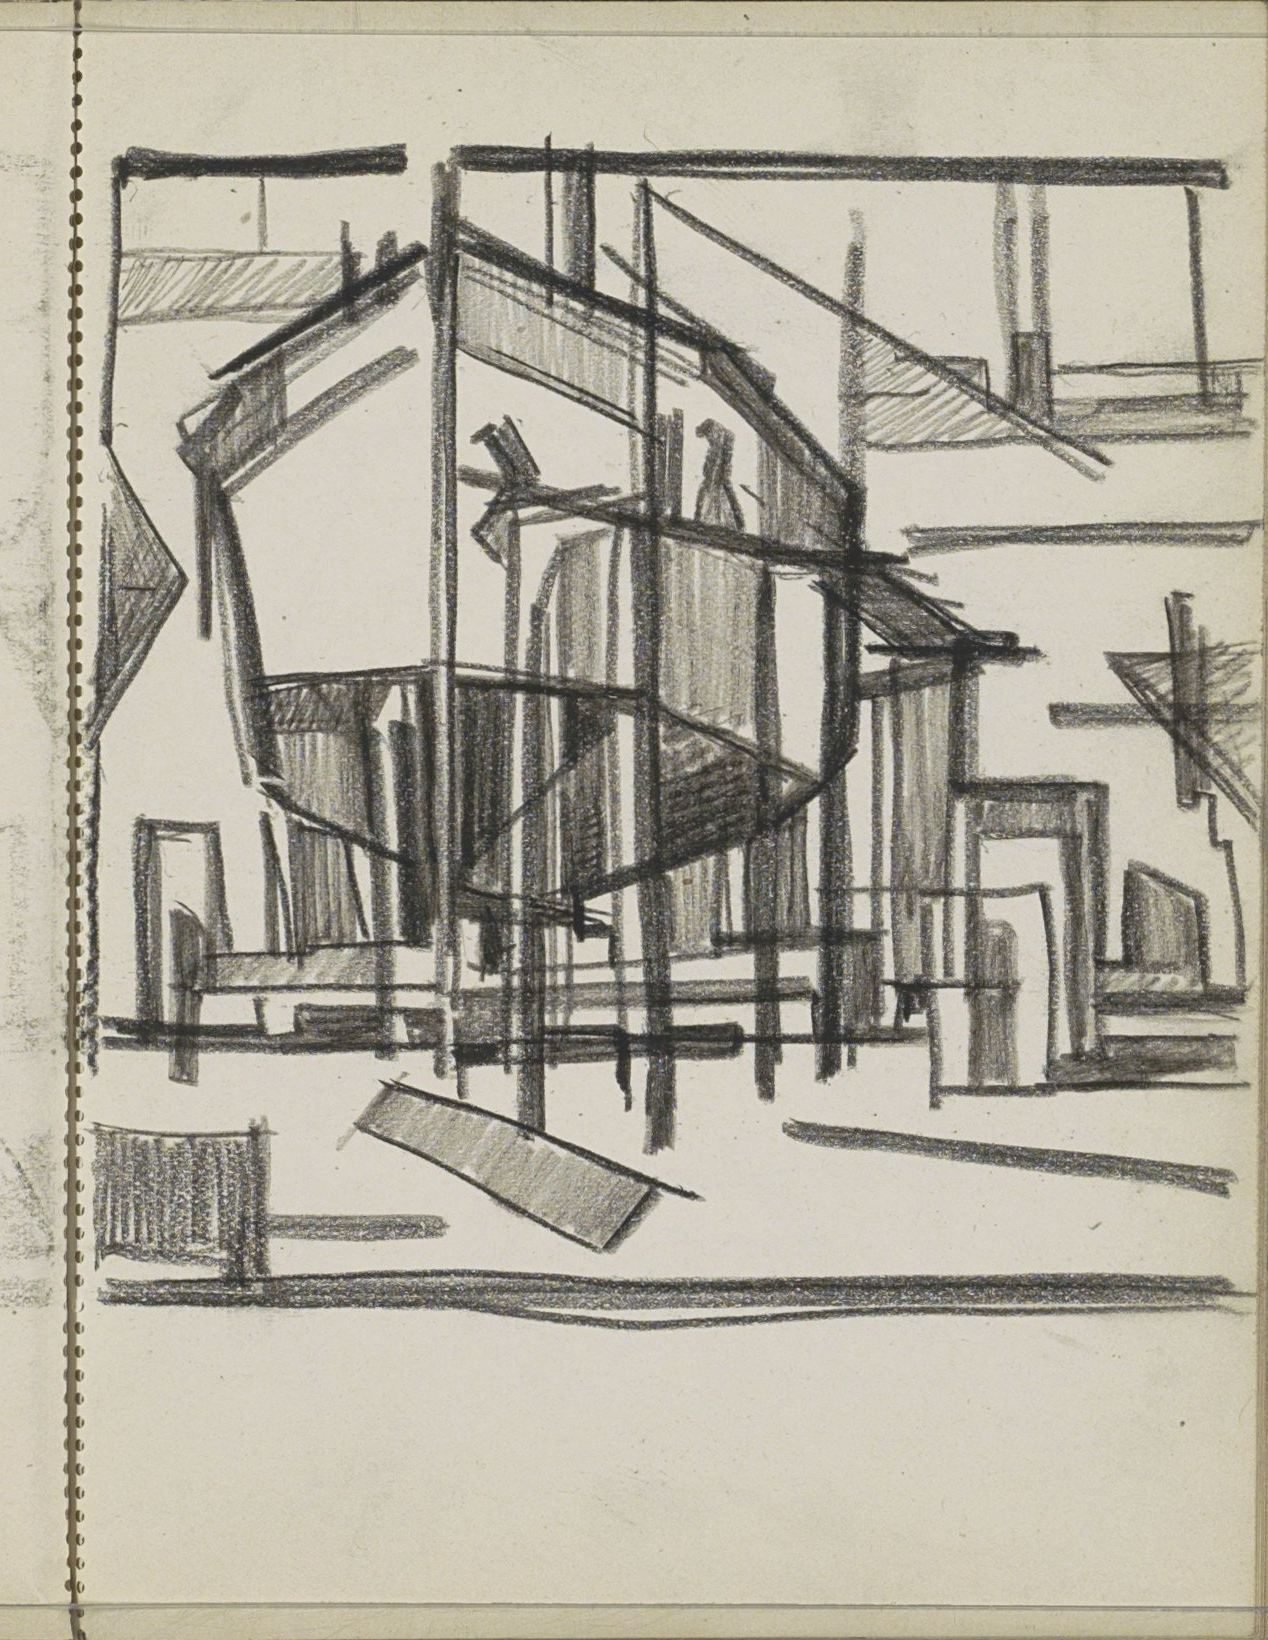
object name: sketchbook leaf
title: Schip op een werfhelling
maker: reijer stolk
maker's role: draughtsman, print maker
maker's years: 1896-1945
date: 1906-1945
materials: chalk, paper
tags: sailing-ship, sailing-boat, pier, quay, wharf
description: Blad 33 recto uit een schetsboek met 53 bladen.